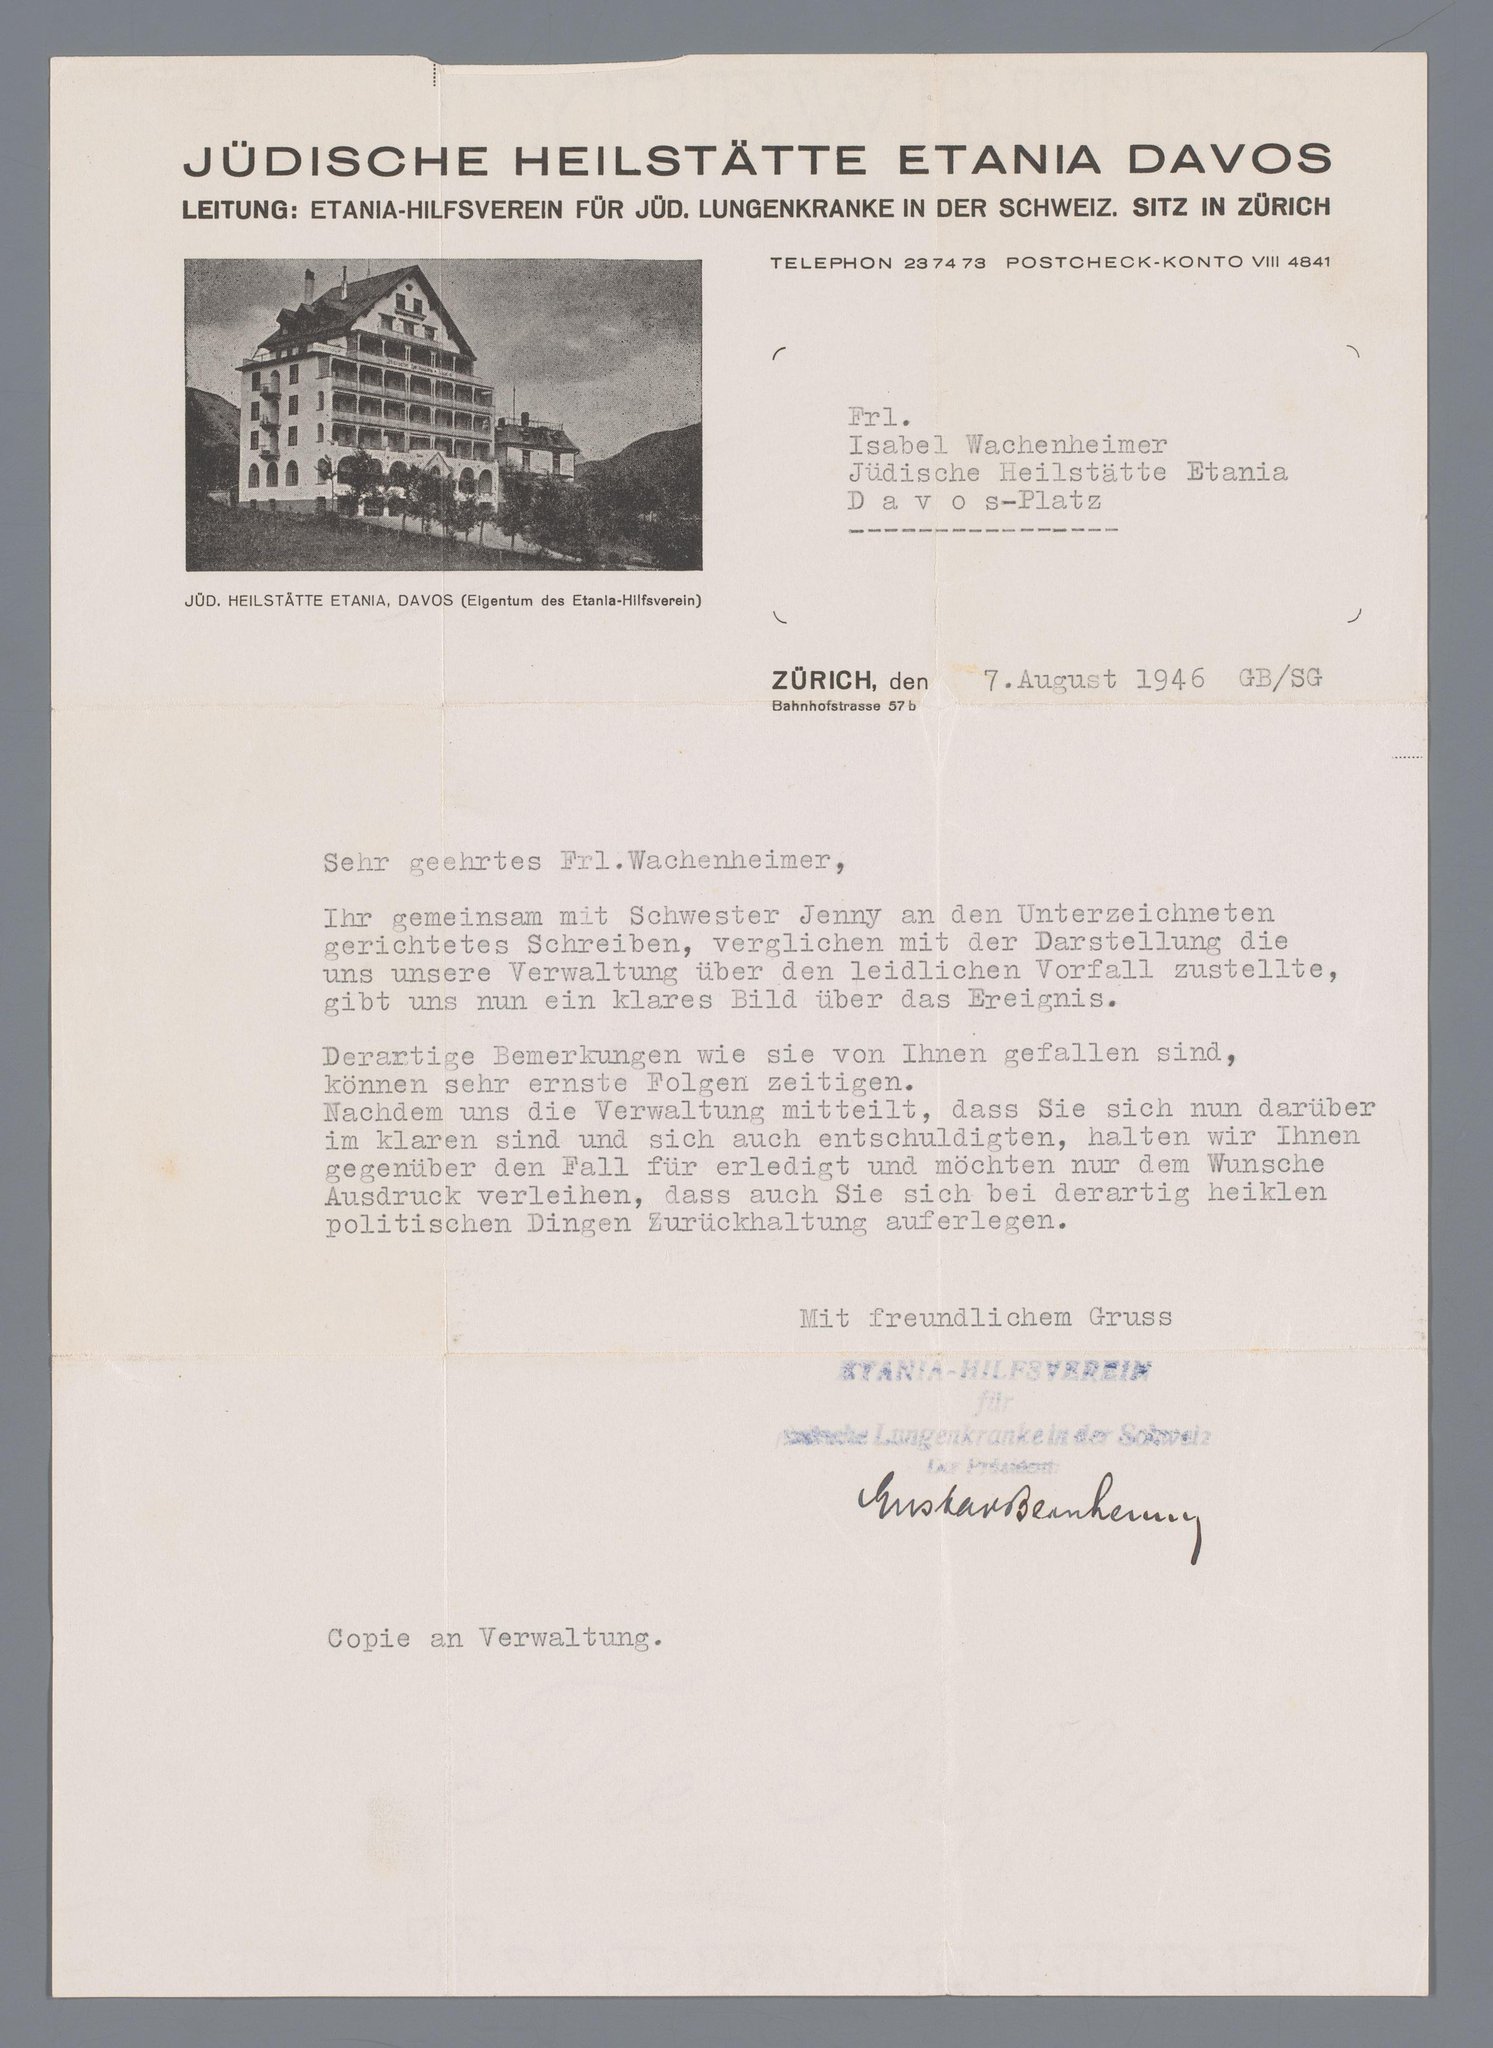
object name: letter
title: Brief van de jüdische Heilstätte Etania in Davos aan Isabel Wachenheimer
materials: paper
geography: davos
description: Dit object is onderdeel van de nalatenschap van Isabel Elon-Wachenheimer (1928-2010). Tot haar overlijden behoorde het samen met de andere objecten uit de nalatenschap tot haar privédomein van Isabel Wachenheimer. In die particuliere context zijn deze objecten tezamen en individueel aandenkens - aan de jeugd, ouders en familie van Isabel Wachenheimer vóór en tijdens de Shoah en aan haar leven na de Tweede Wereldoorlog. Isabel Wachenheimer, die van juni 1943 tot mei 1945 gevangen zat in Kamp Westerbork, Theresienstadt, Auschwitz, Lenzing a/d Oberdonau (een buitenkamp van Mauthausen), overleefde de Shoah. Haar ouders – Eugène Wachenheimer en Else Wachenheimer-Moos - werden op 14 oktober 1944 in Auschwitz-Birkenau vermoord.